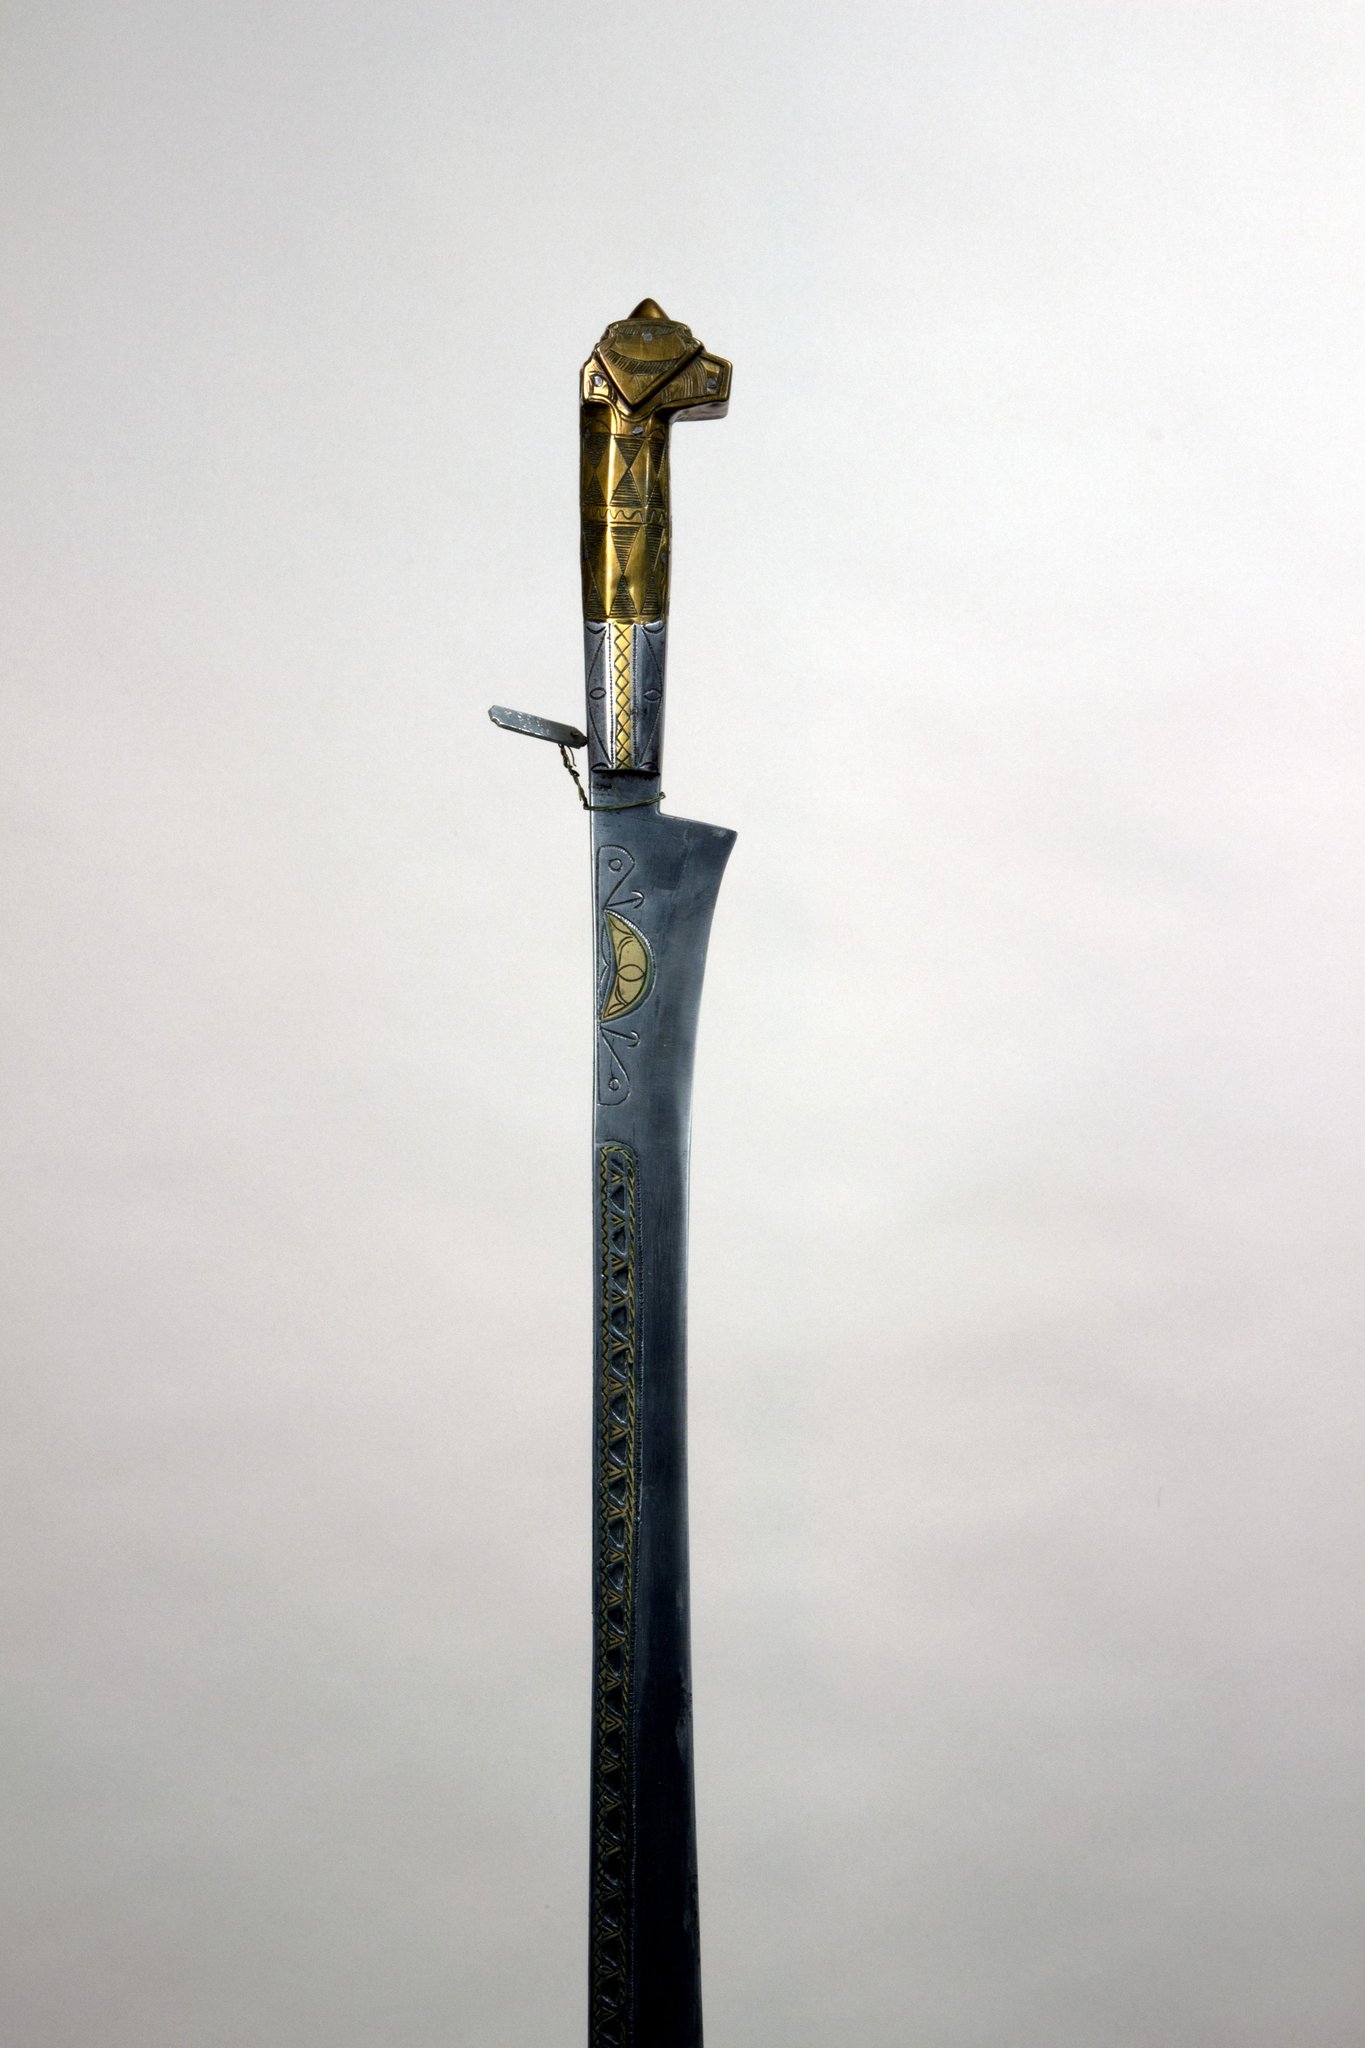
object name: sword flyssa with scabbard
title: Sword (Flyssa) with Scabbard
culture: algerian or kabyle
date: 1801-1900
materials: brass, steel, wood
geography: morocco